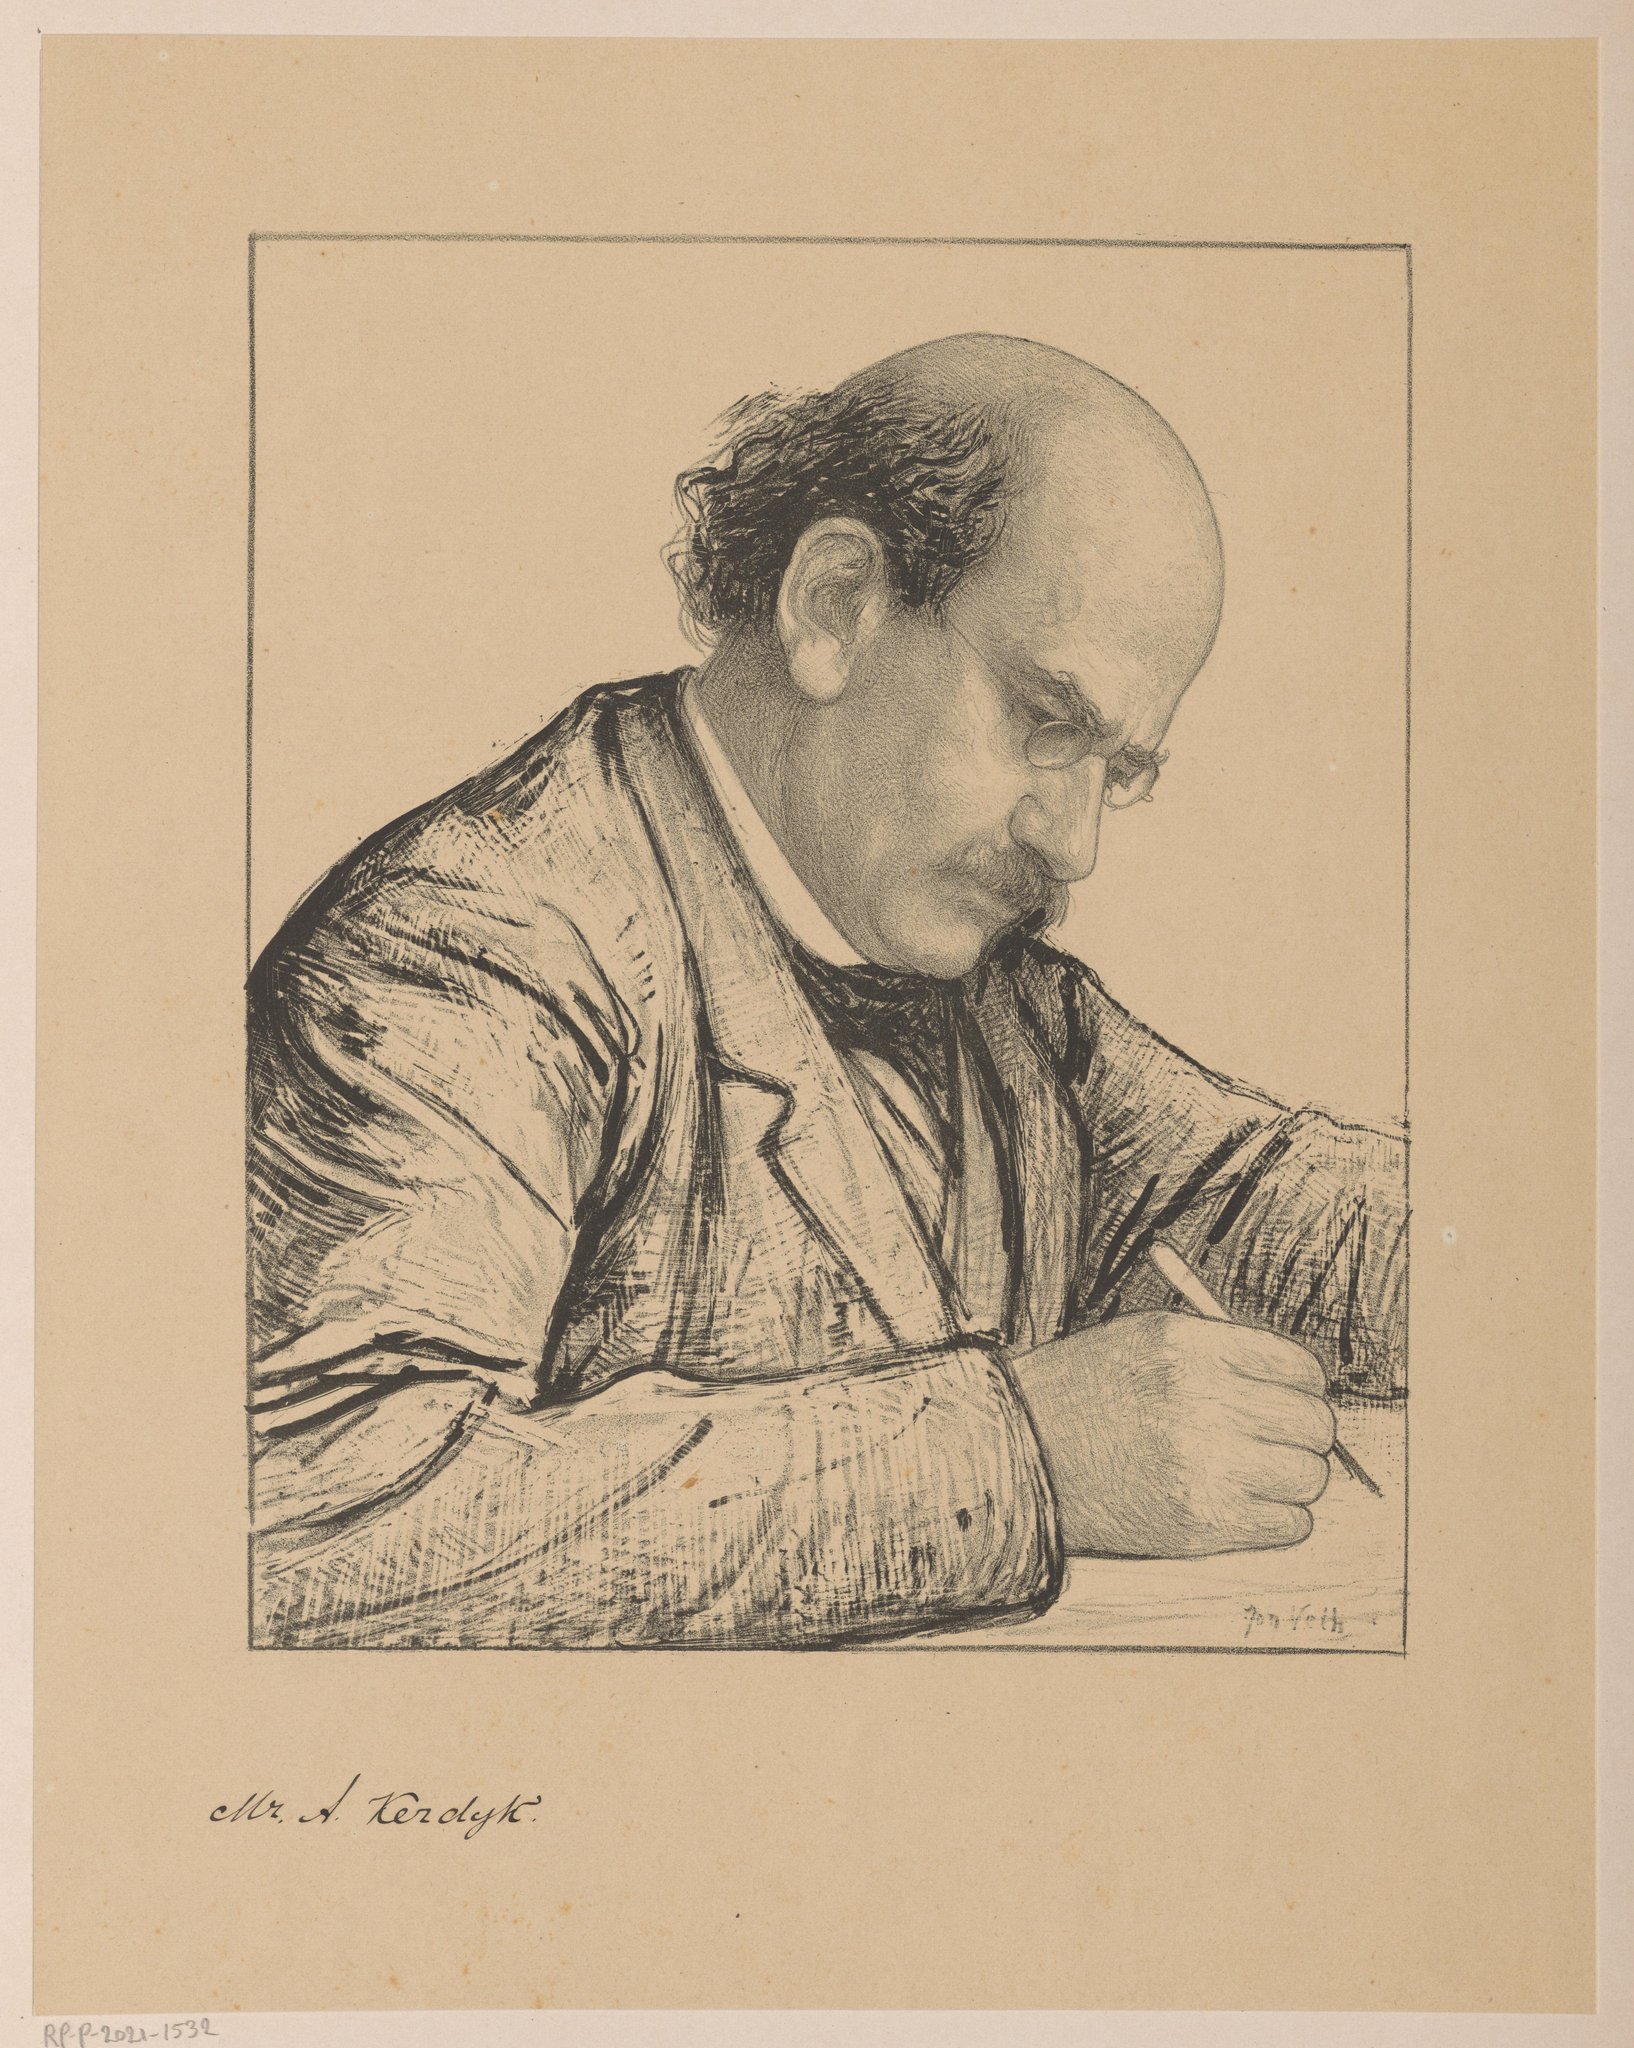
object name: print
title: Portret van Arnold Kerdijk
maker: jan veth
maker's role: designer, draughtsman, painter, print maker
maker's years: 1864-1925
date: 1889-1891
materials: paper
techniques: lithograph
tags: historical persons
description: Latere staat gebruikt als bijvoegsel van: De Amsterdammer. Weekblad voor Nederland, 15 november 1891.